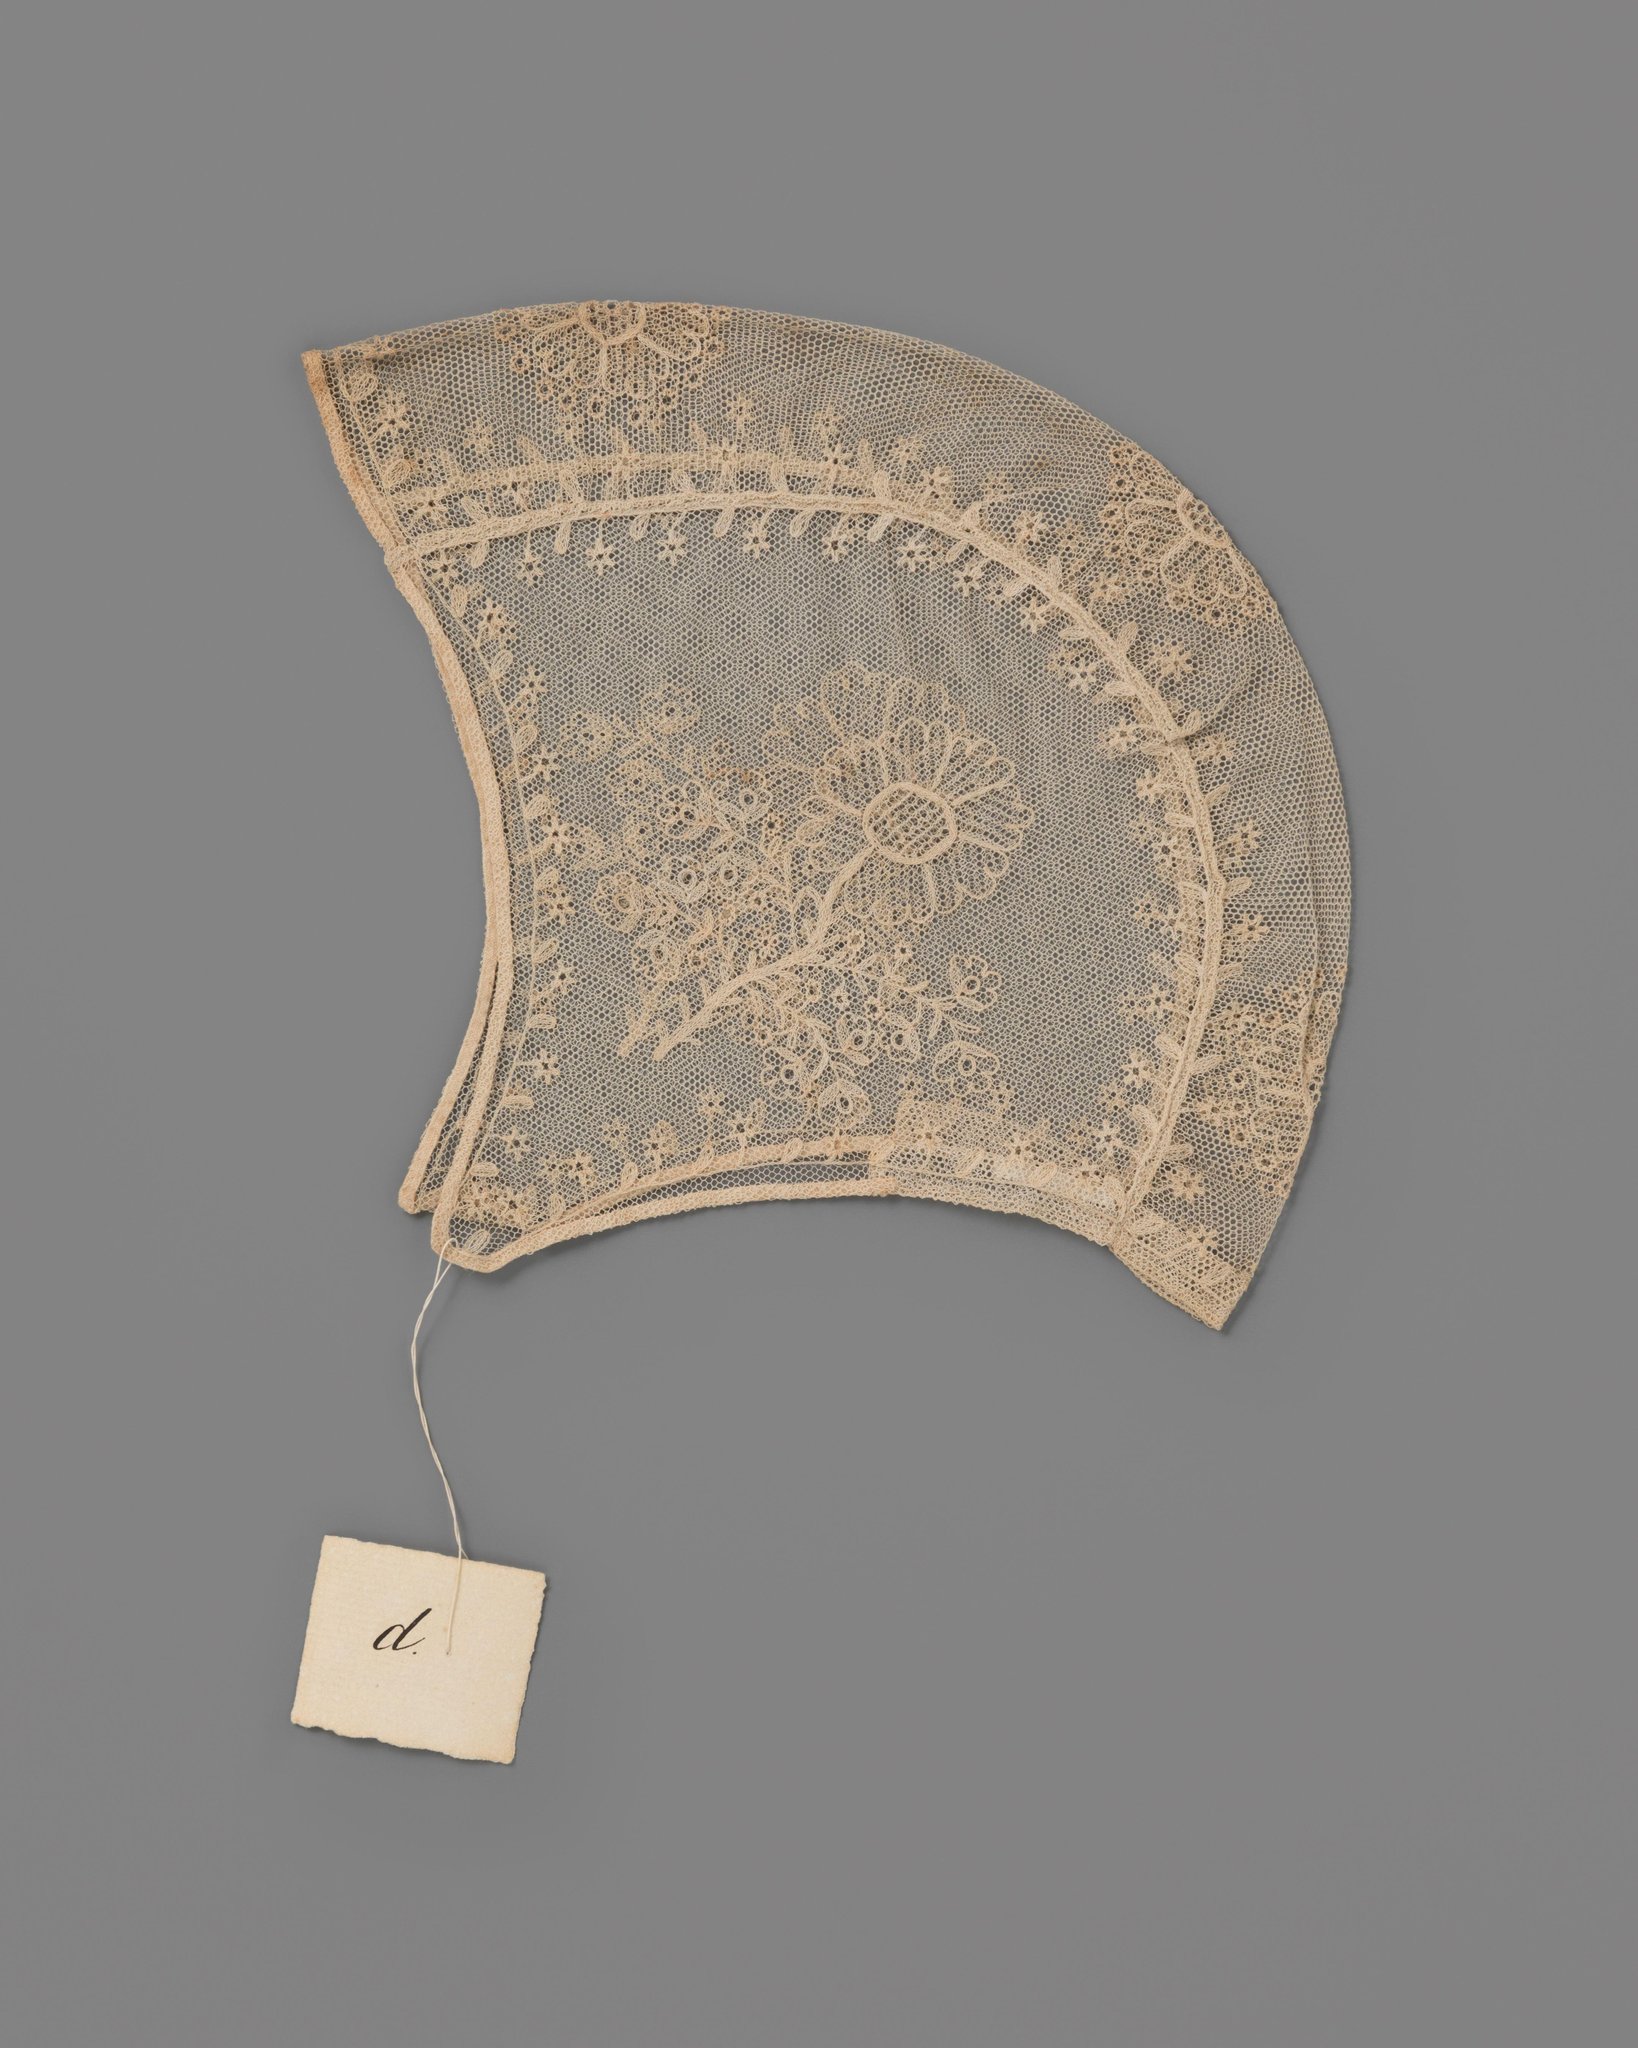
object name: cap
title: Muts van tule versierd met tamboereerwerk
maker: Anonymous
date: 1840-1870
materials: fiber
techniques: tambouring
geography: netherlands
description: Muts van tule versierd met tamboereerwerk, met een patroon van margrieten, een hele stengel op de zijkanten en bloemen op het tussenstuk.